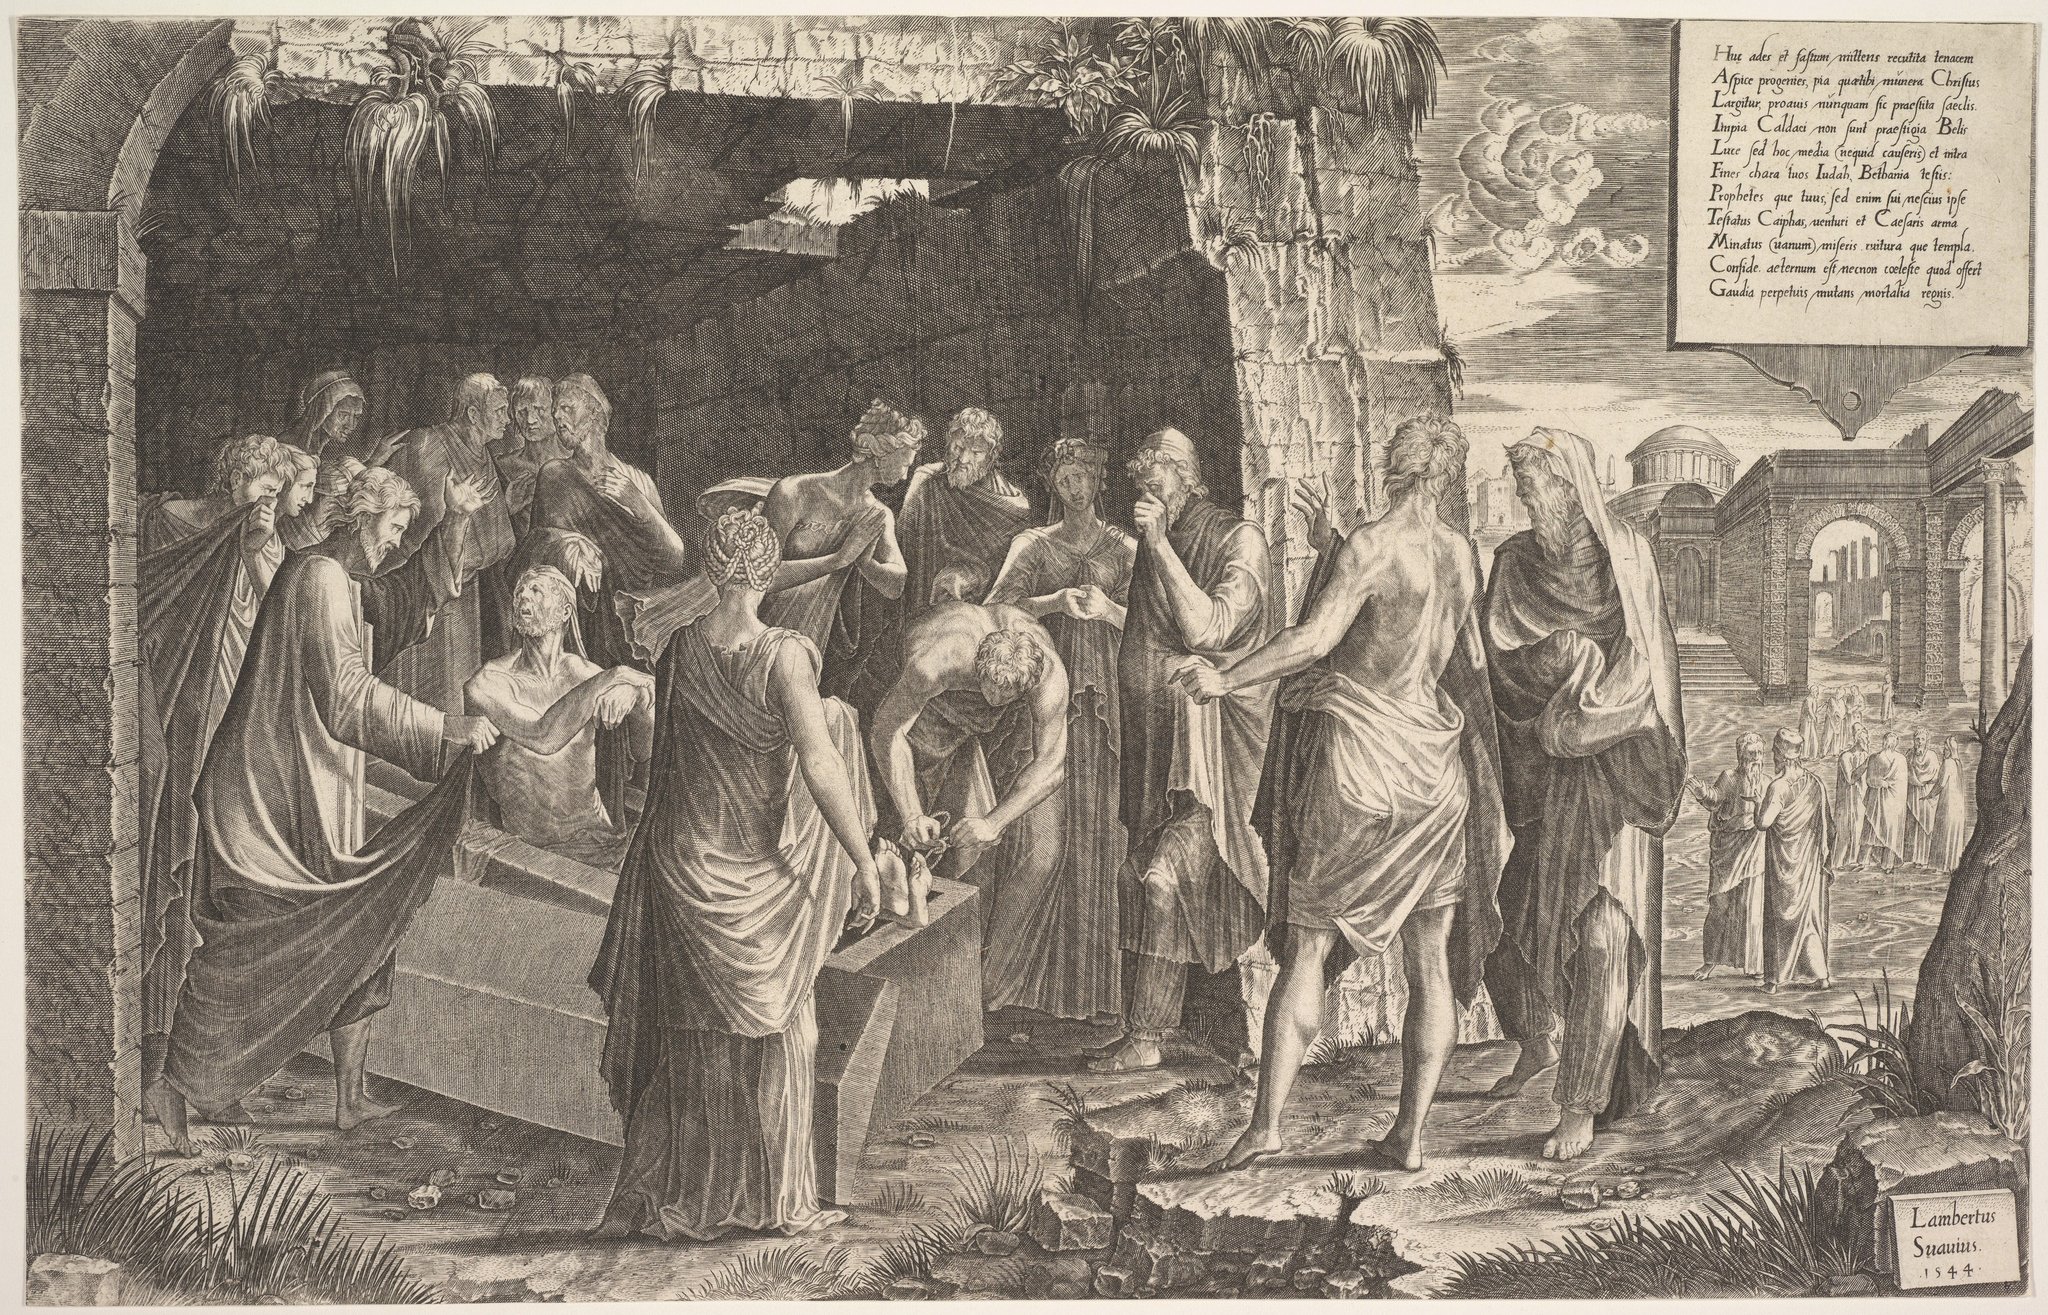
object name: print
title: Raising of Lazurus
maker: lambert suavius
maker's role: artist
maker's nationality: netherlandish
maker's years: 1510-1576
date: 1544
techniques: engraving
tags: men,jesus,saints